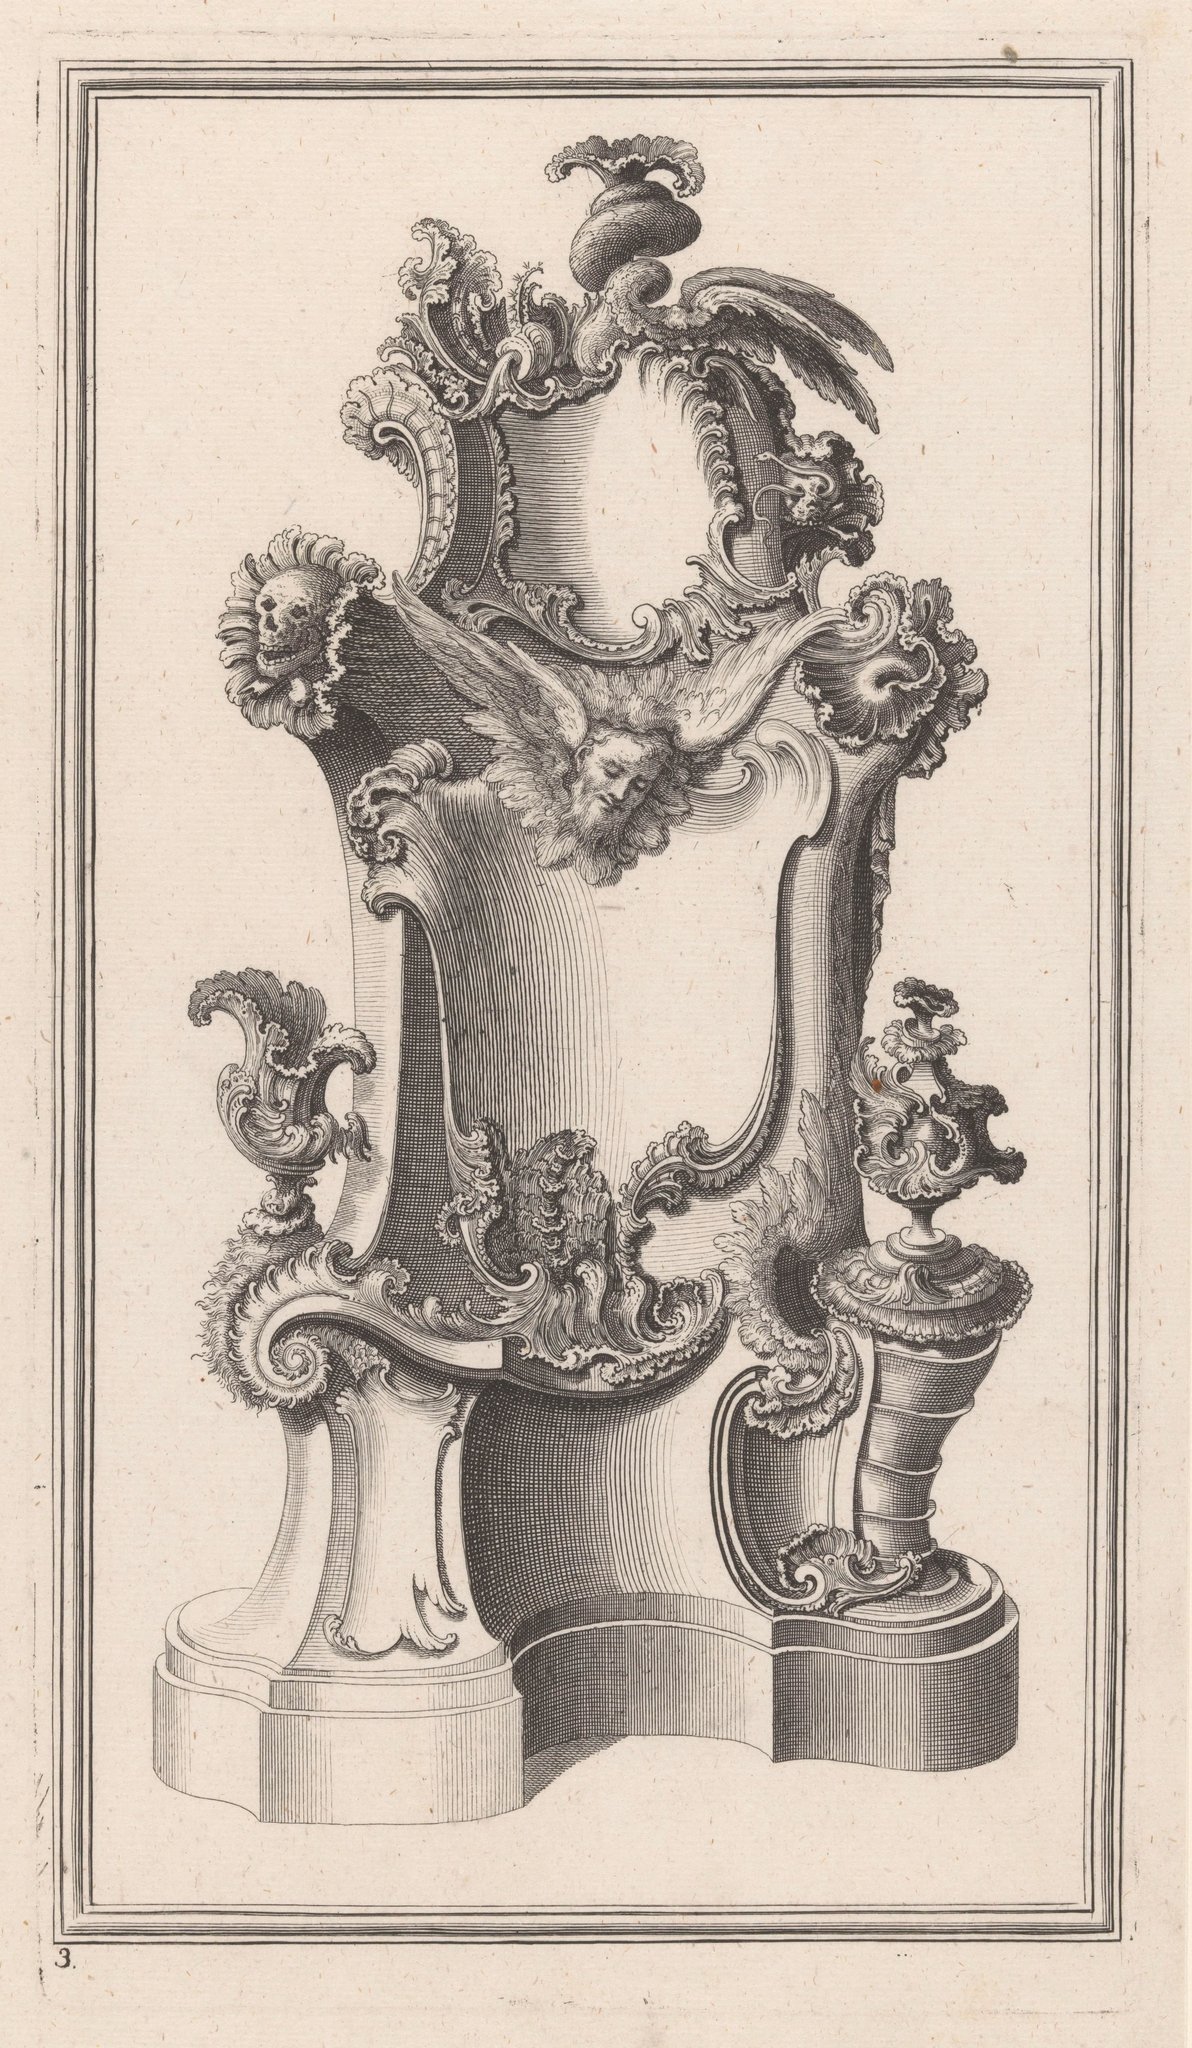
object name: print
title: Ontwerp met vazen en gevleugeld hoofd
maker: balthasar sigmund setletzky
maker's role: print maker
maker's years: 1695-1771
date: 1724-1754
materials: paper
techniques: engraving, etching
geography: augsburg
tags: vase ~ ornament, skull as symbol of 'vanitas', fabulous beings with wings, epitaph, altar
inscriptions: collector's mark: Lugt 2228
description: Ontwerp voor een altaar of epitaaf met rocaille ornamenten en aan weerszijden rocaille vazen. Aan de bovenzijde een doodshoofd en een mannengezicht met baard omgeven door vleugels.